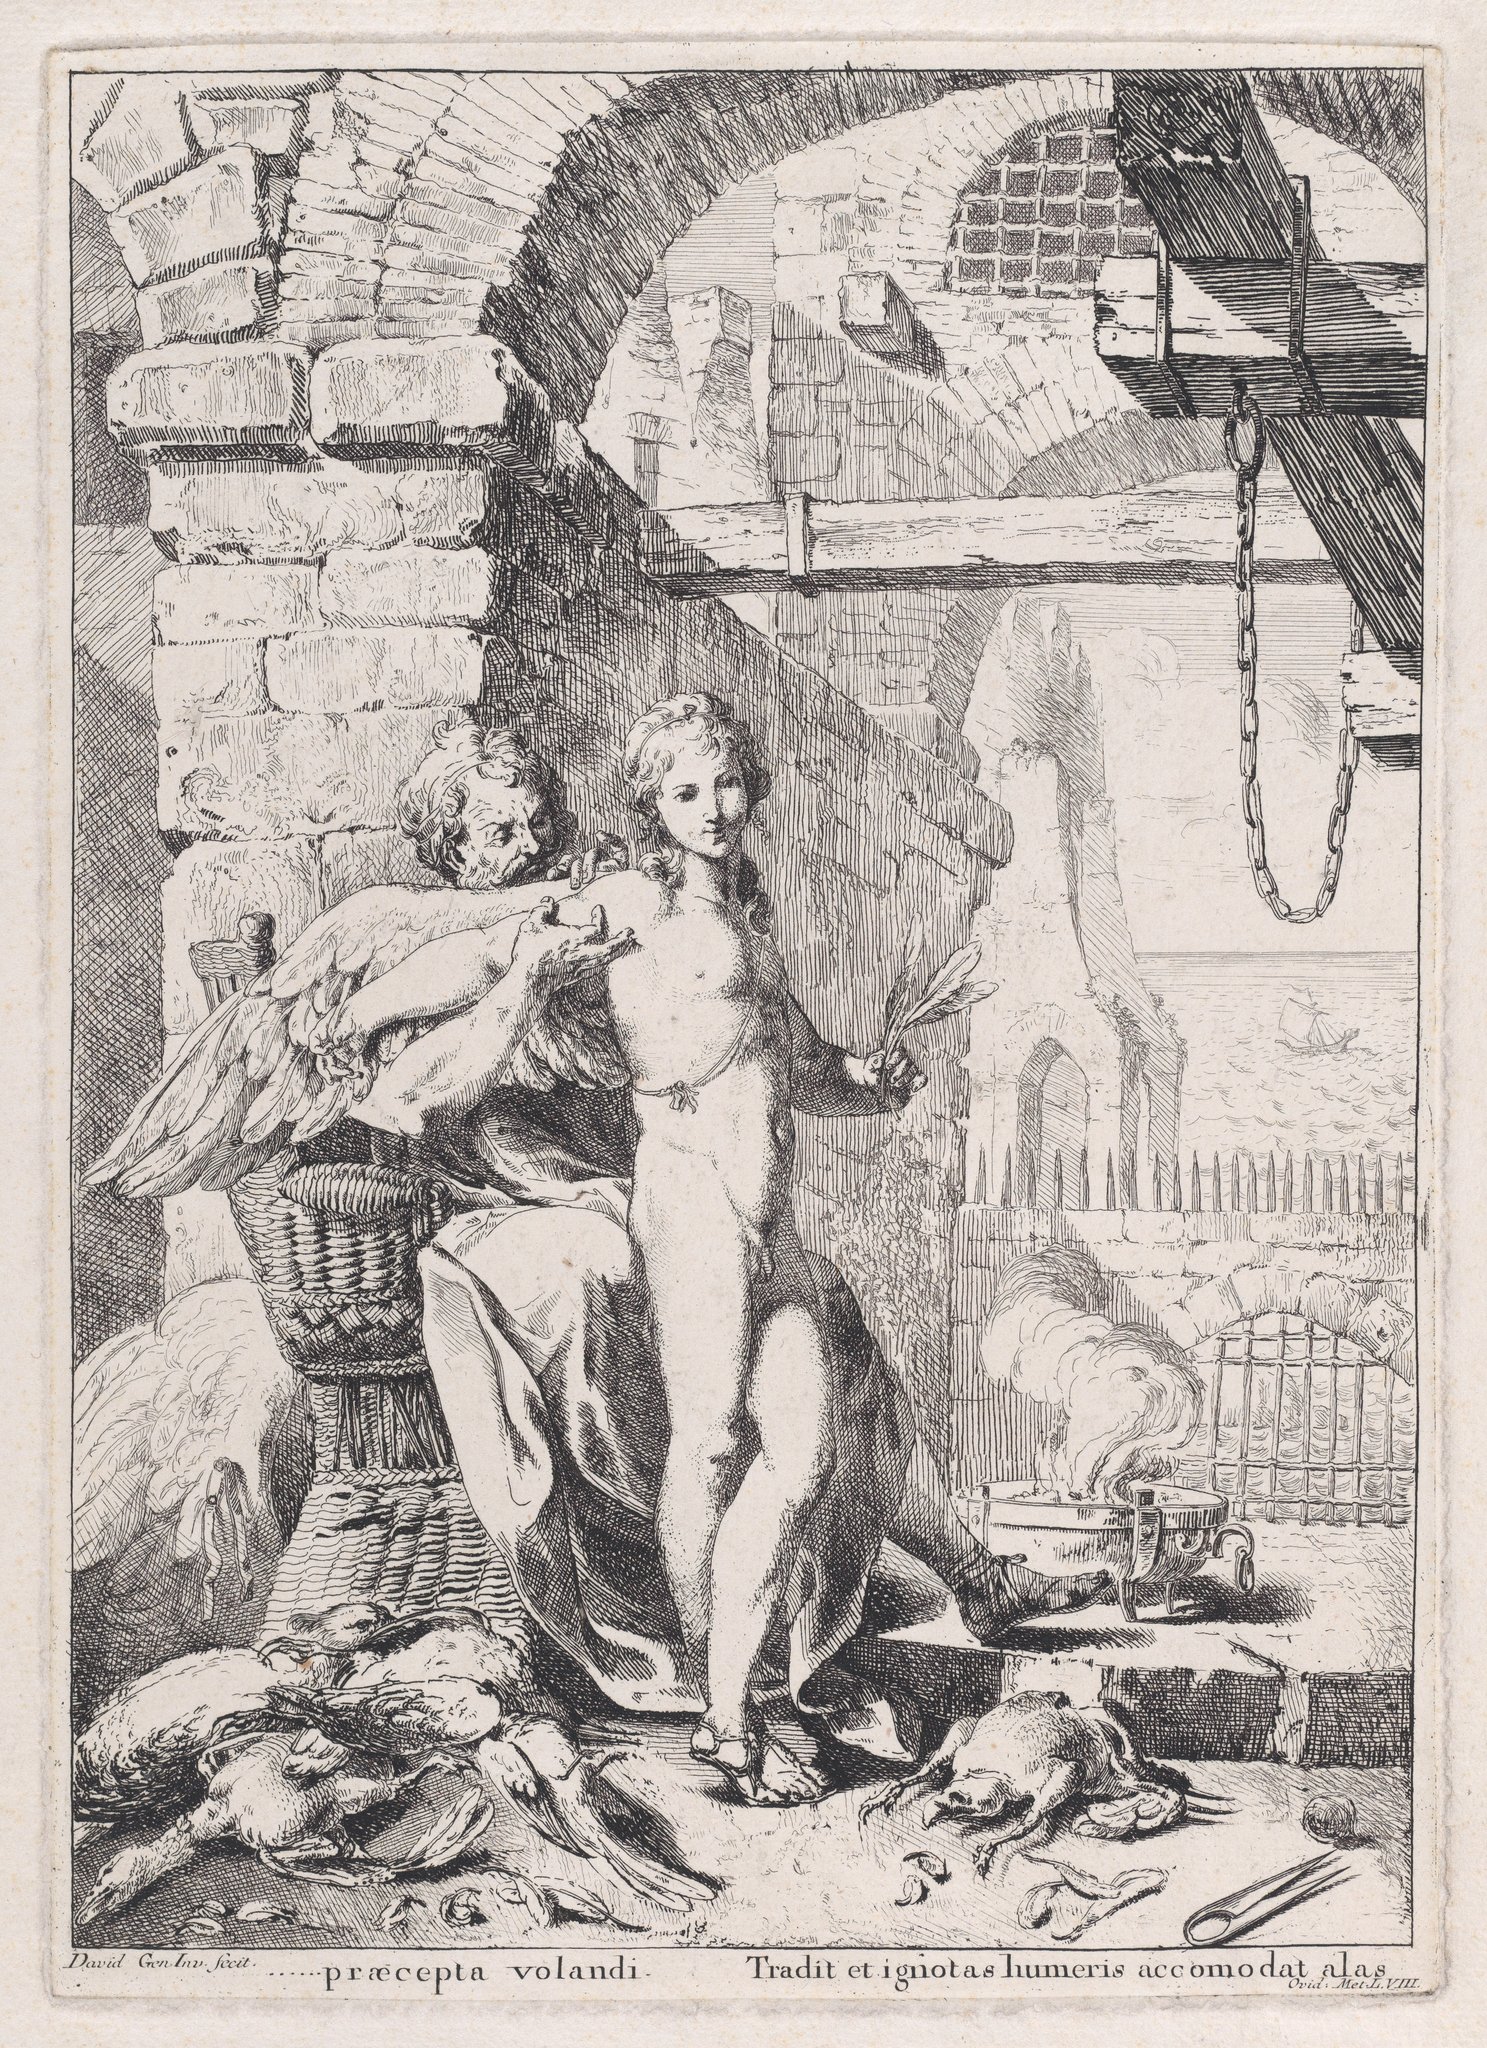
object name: print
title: Icarus and Daedalus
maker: giovanni david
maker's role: artist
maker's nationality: italian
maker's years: 1749-1790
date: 1775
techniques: etching